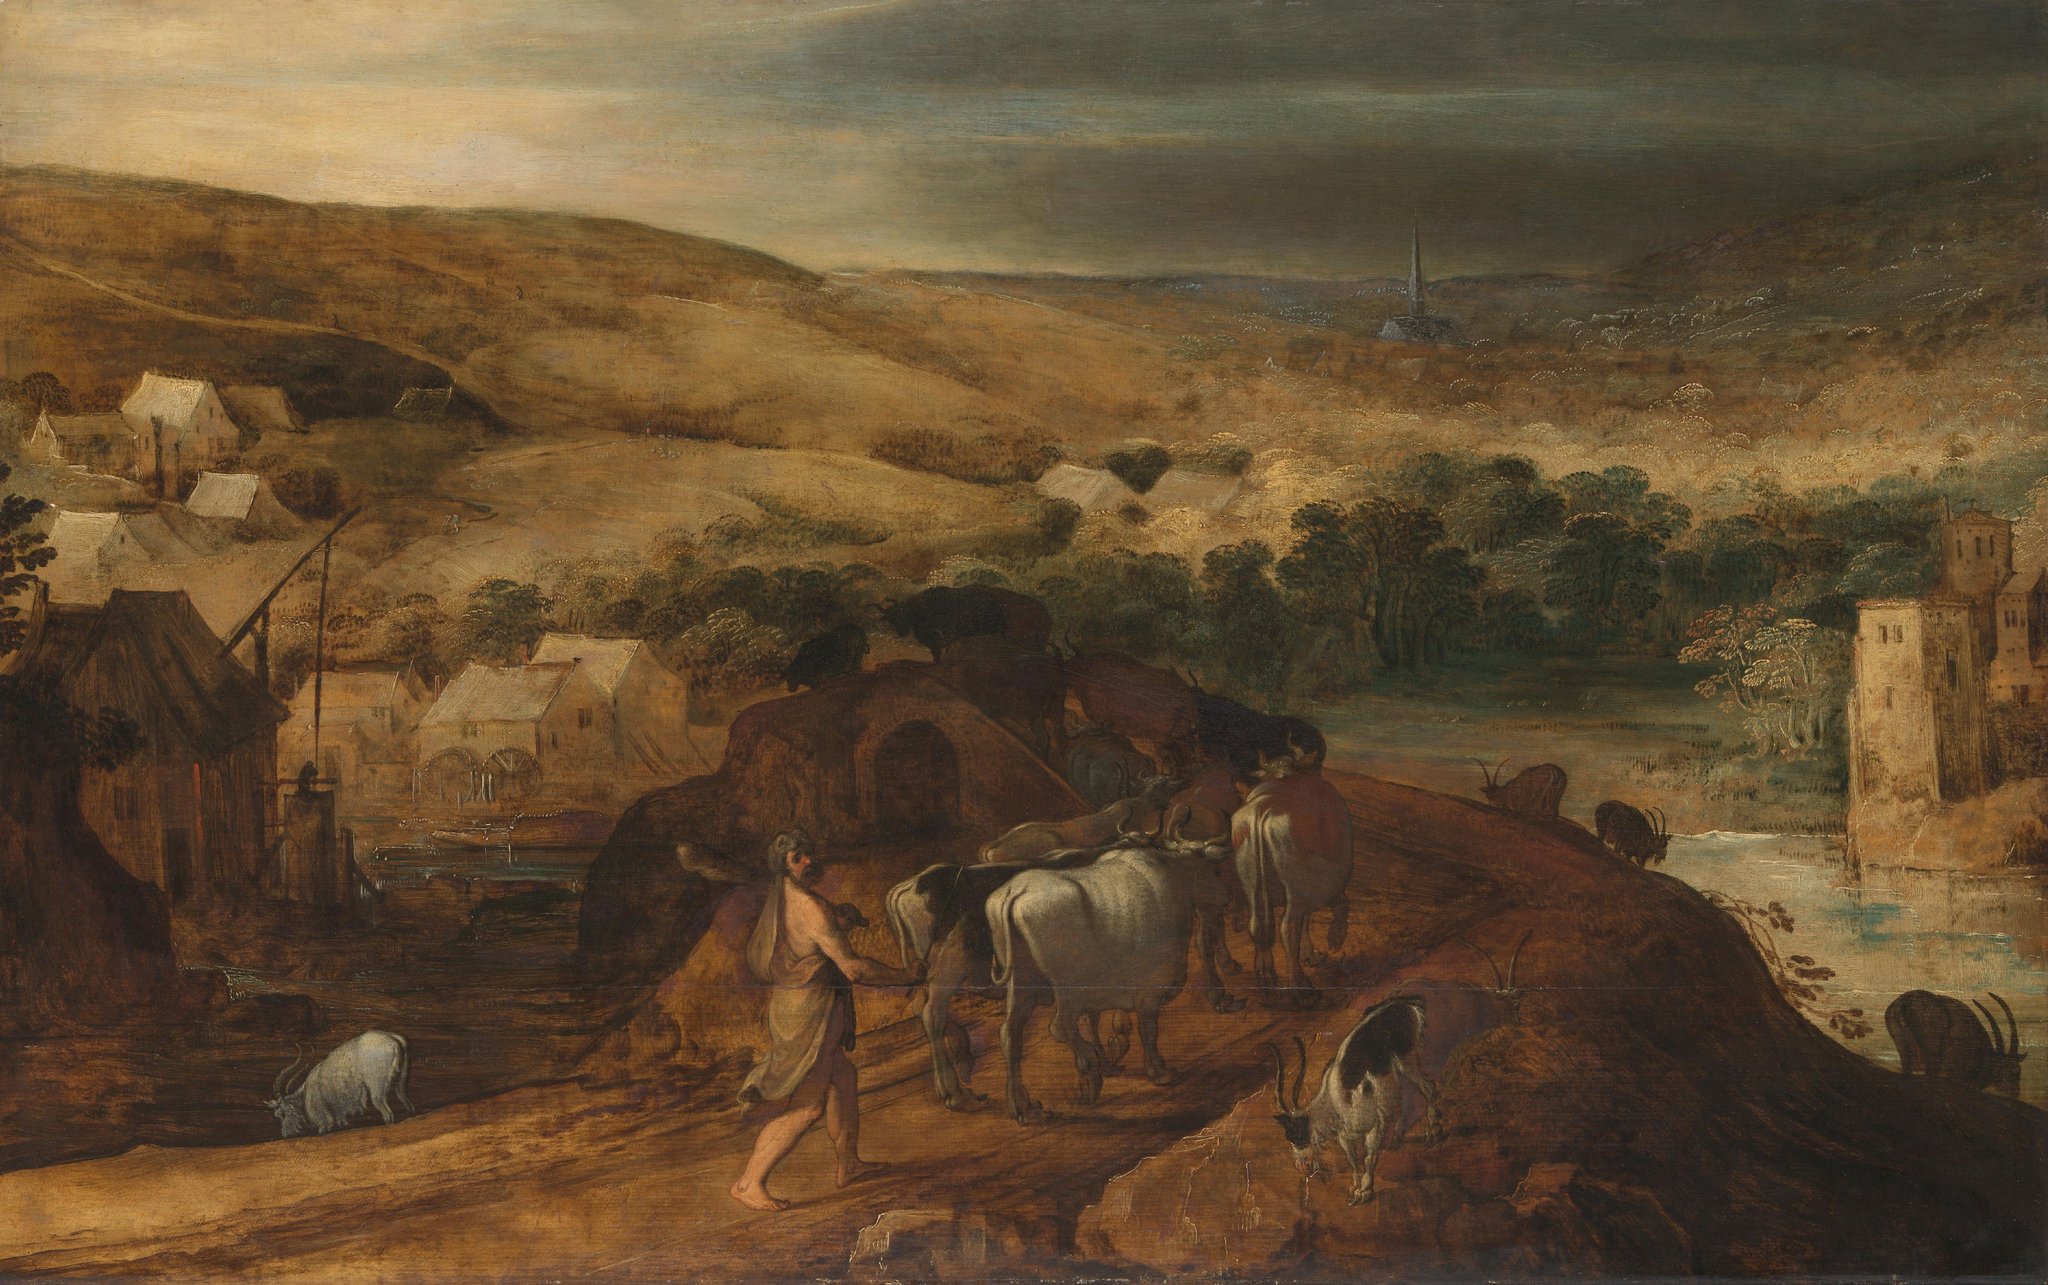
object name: painting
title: Hercules Steals the Oxen of Geryon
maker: joos de momper (ii)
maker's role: draughtsman, painter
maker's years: 1564-1635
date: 1590-1635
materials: oil, panel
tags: low hill country (+ landscape with figures, staffage), (10) the cattle of geryon secured by hercules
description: Hercules steelt de kudde van Geryones. Door een heuvelachtig landschap drijft Hercules, met knots over de schouder, de koeien over een weg met een stenen brug. Links een boerderij met een waterput en een watermolen. Aan weerszijden van de weg grazen geiten.